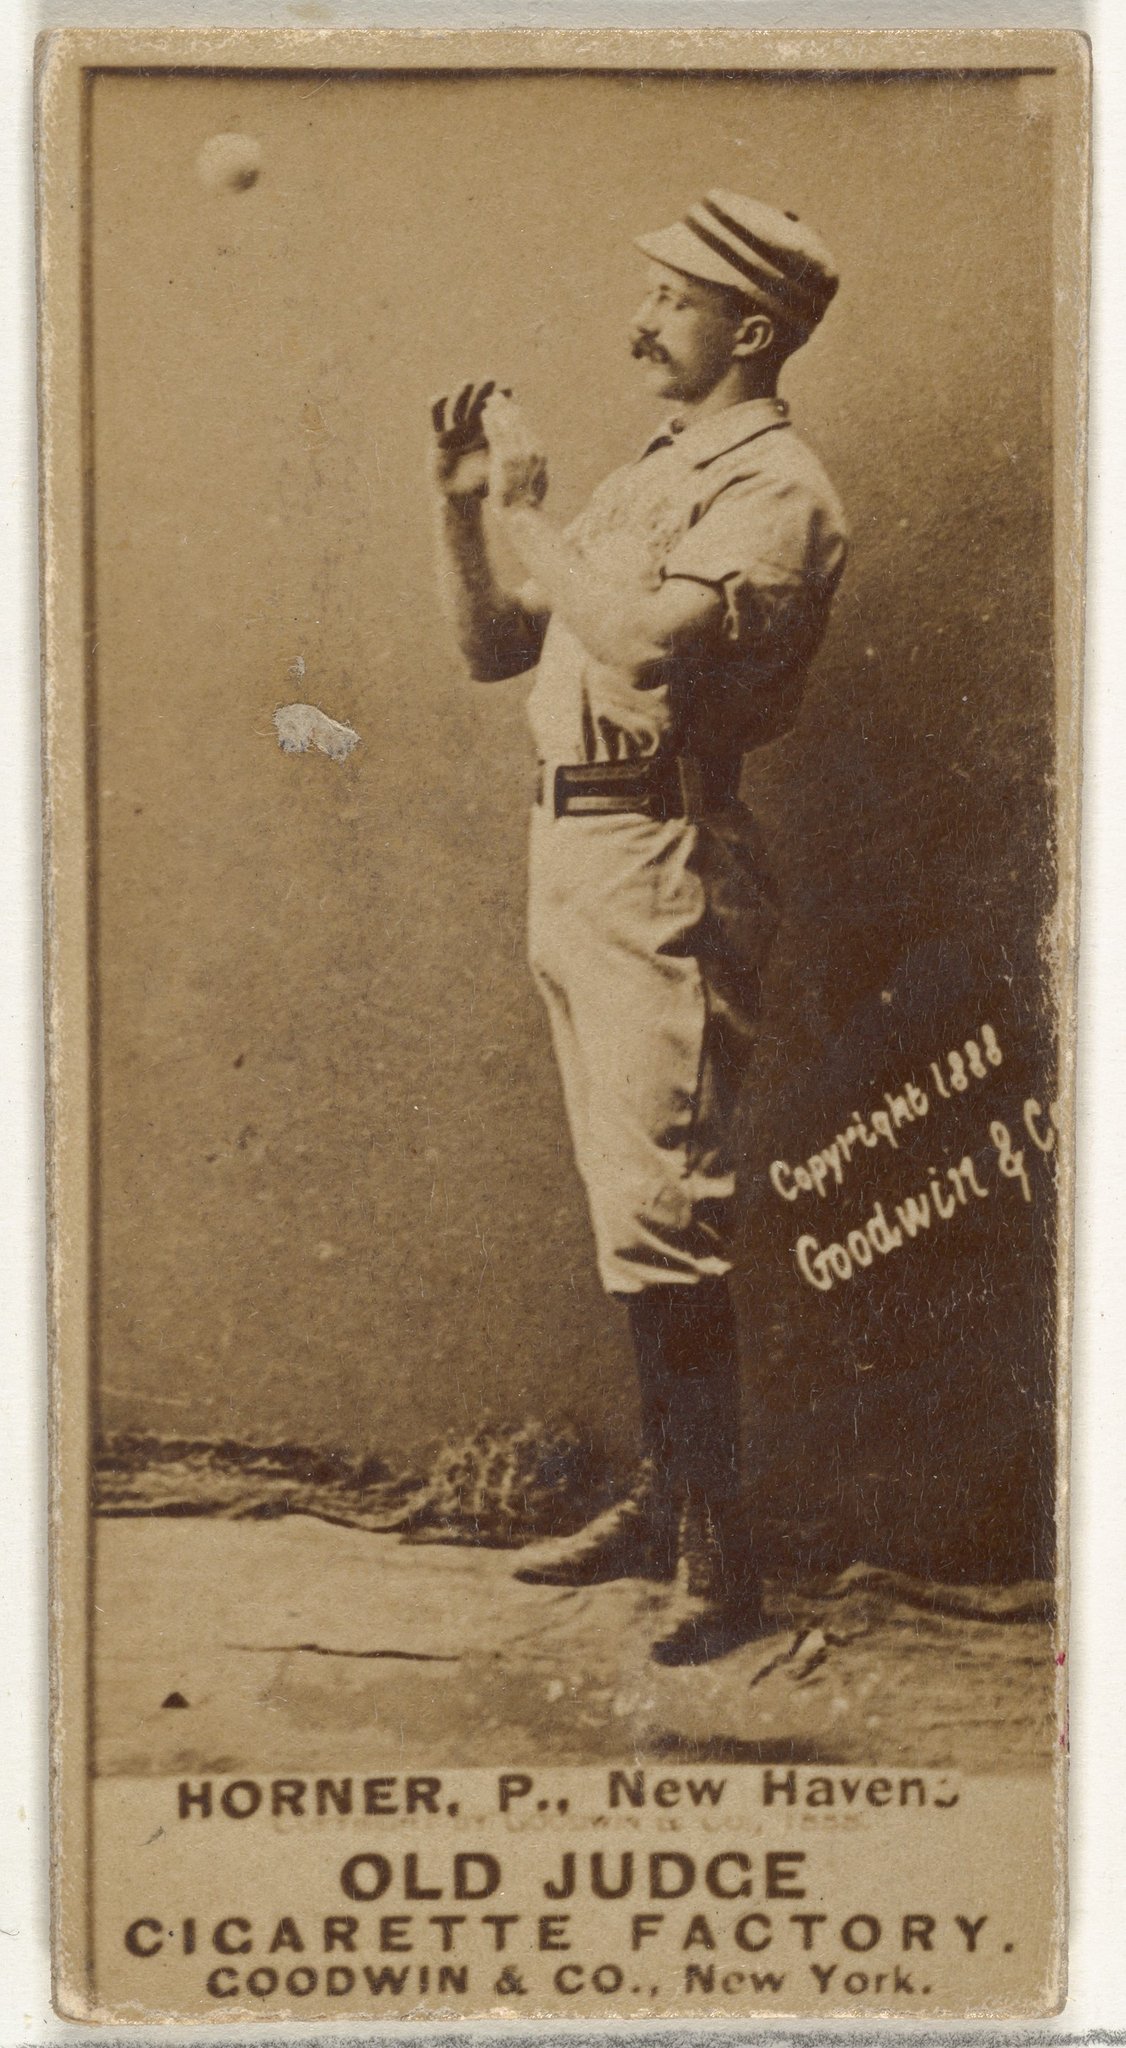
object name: baseball card, photograph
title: William "Jack" Frank Horner, Pitcher, New Haven, from the Old Judge series (N172) for Old Judge Cigarettes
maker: goodwin & company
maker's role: publisher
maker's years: 1850-1950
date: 1888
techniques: albumen silver print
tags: men,portraits,baseball,athletes